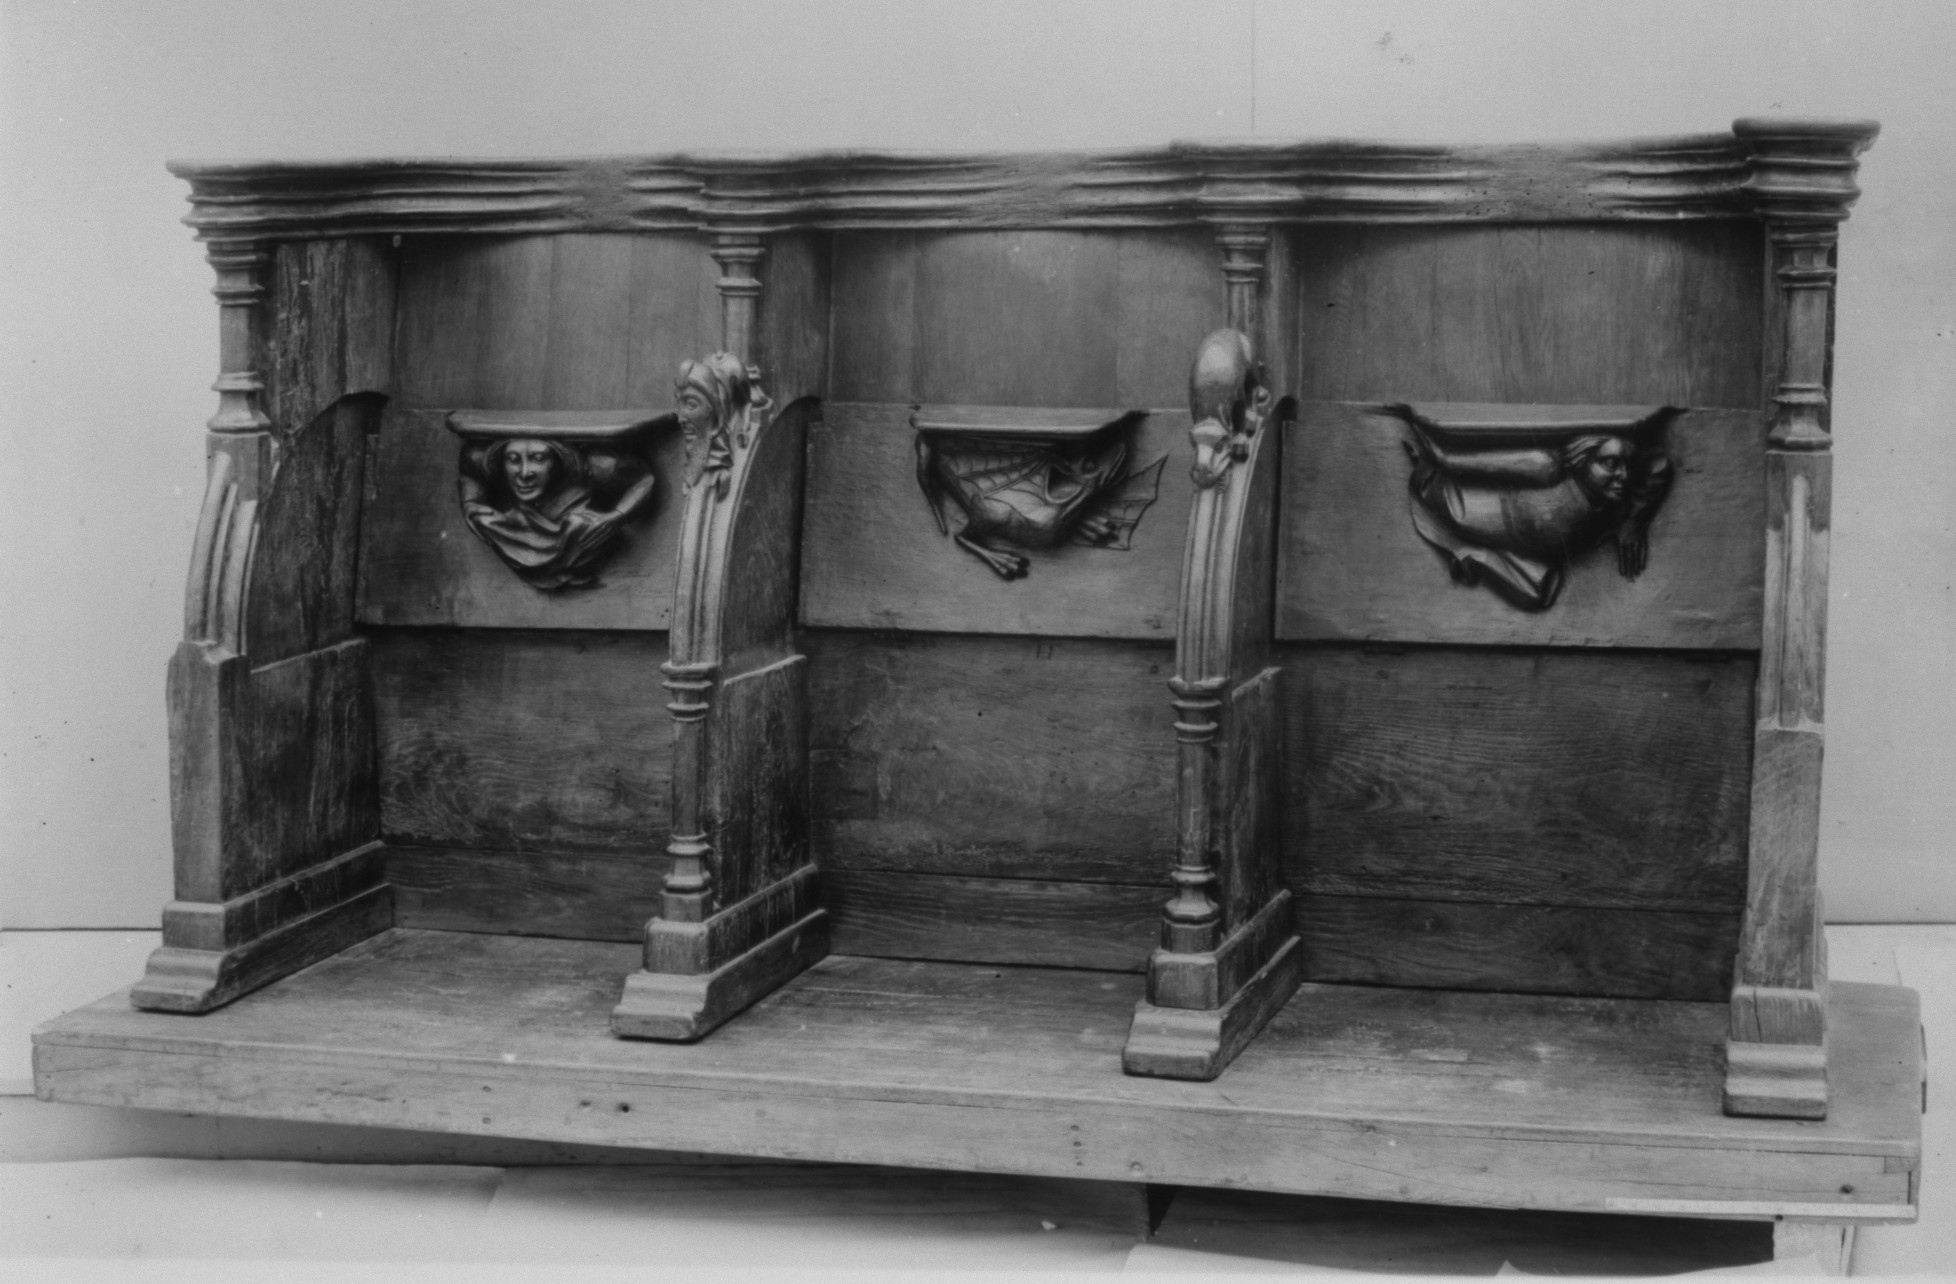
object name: choir stall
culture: french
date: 1401-1500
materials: wood